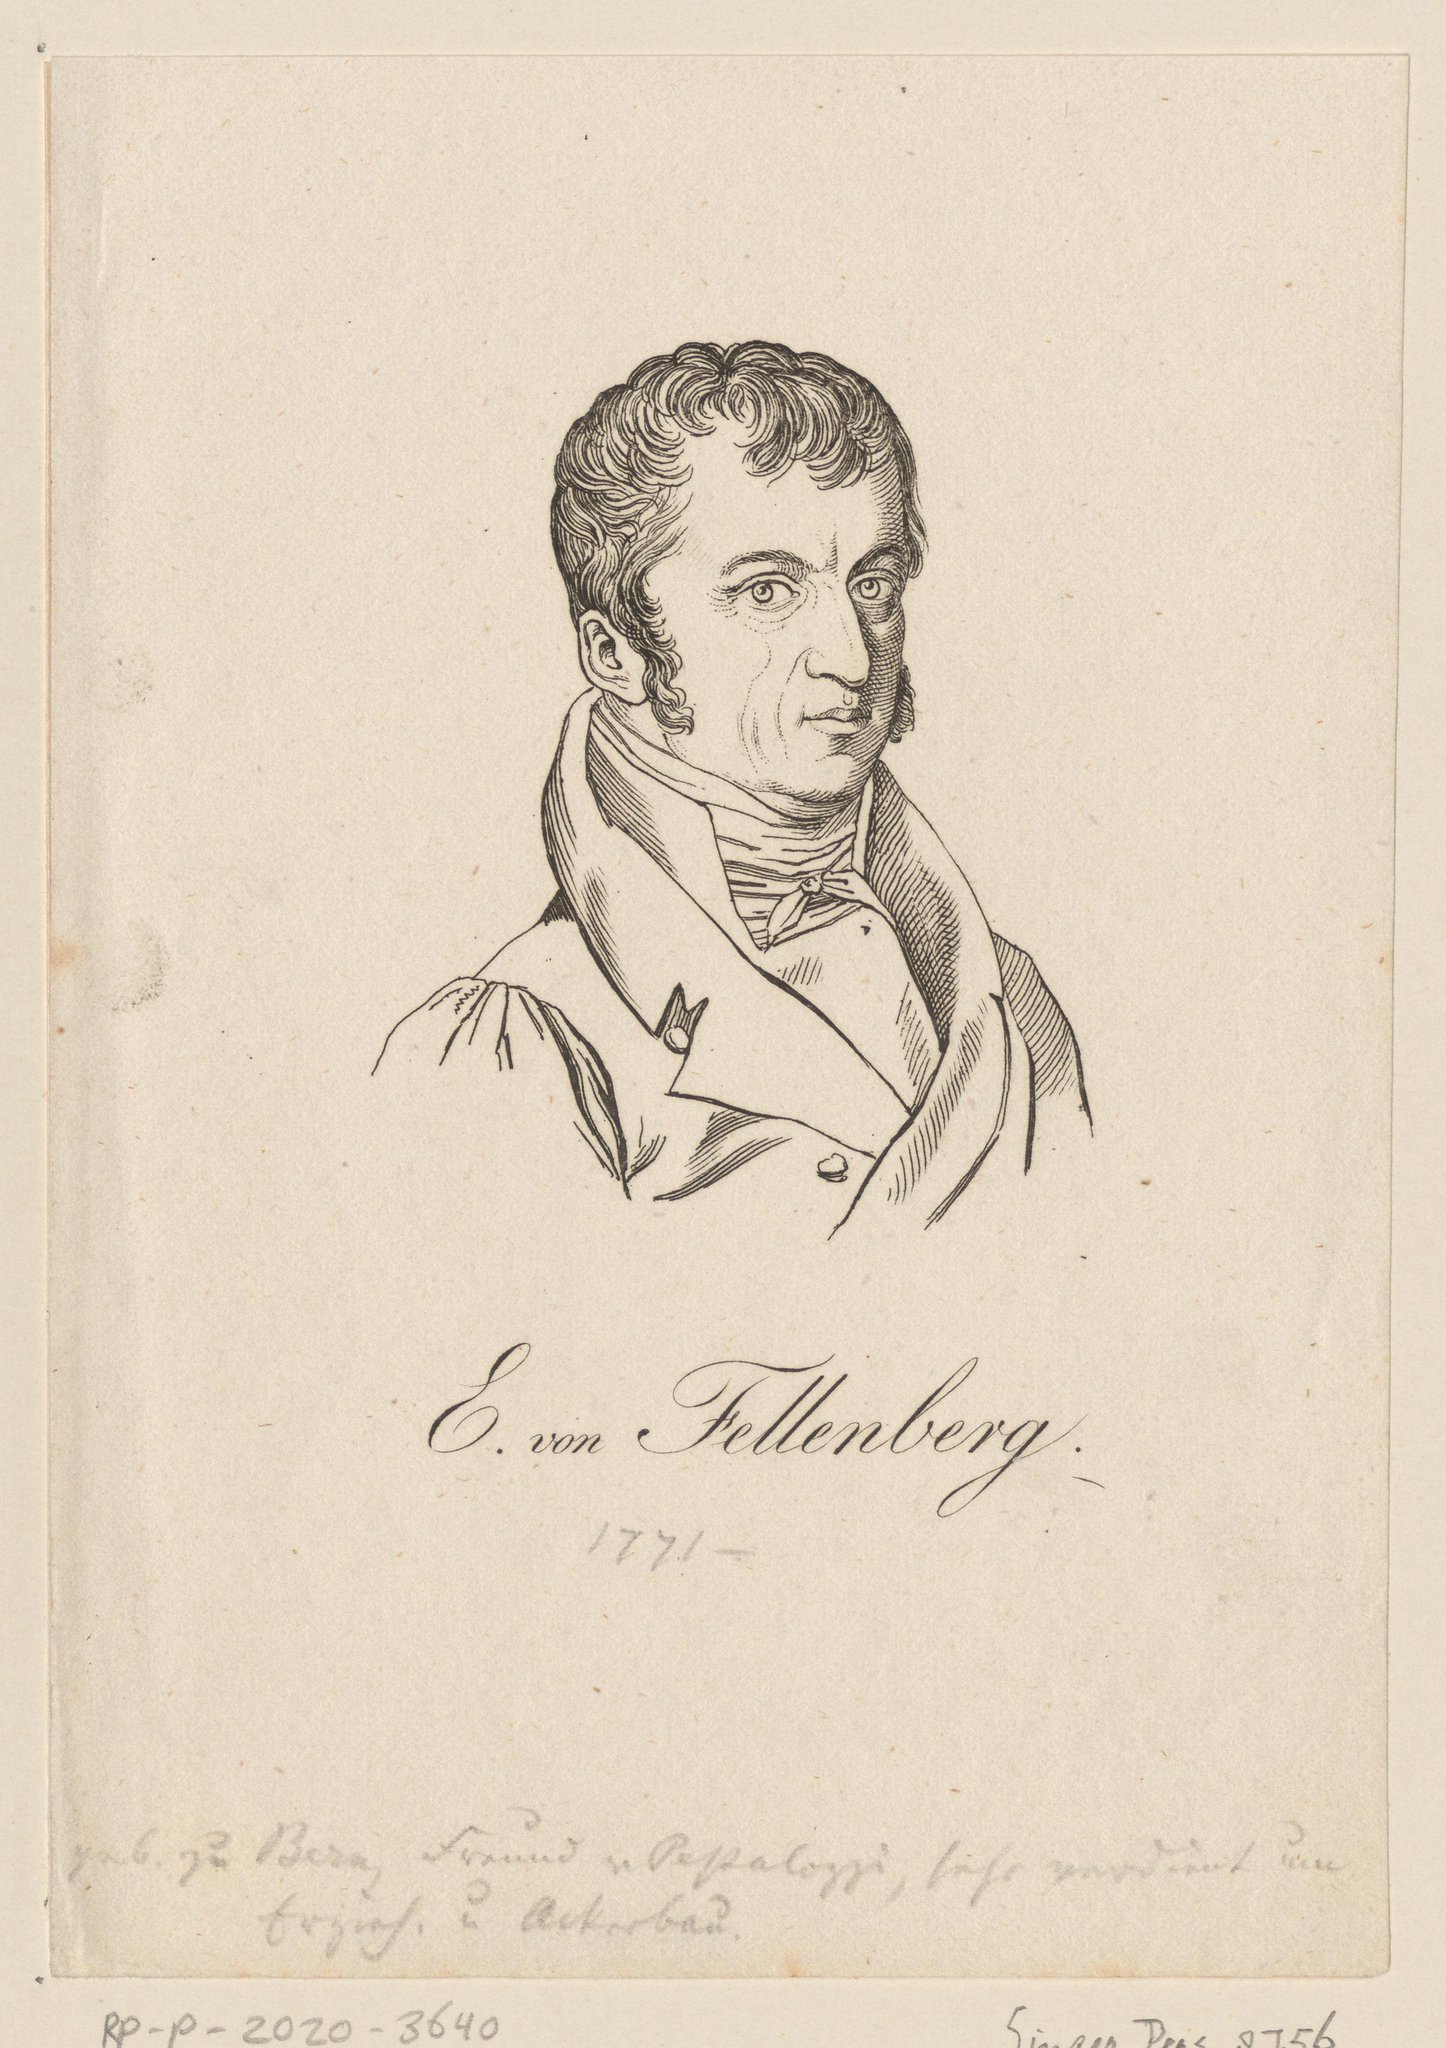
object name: print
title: Portret van Philipp Emanuel von Fellenberg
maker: Anonymous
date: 1800-1850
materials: paper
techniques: etching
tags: historical persons